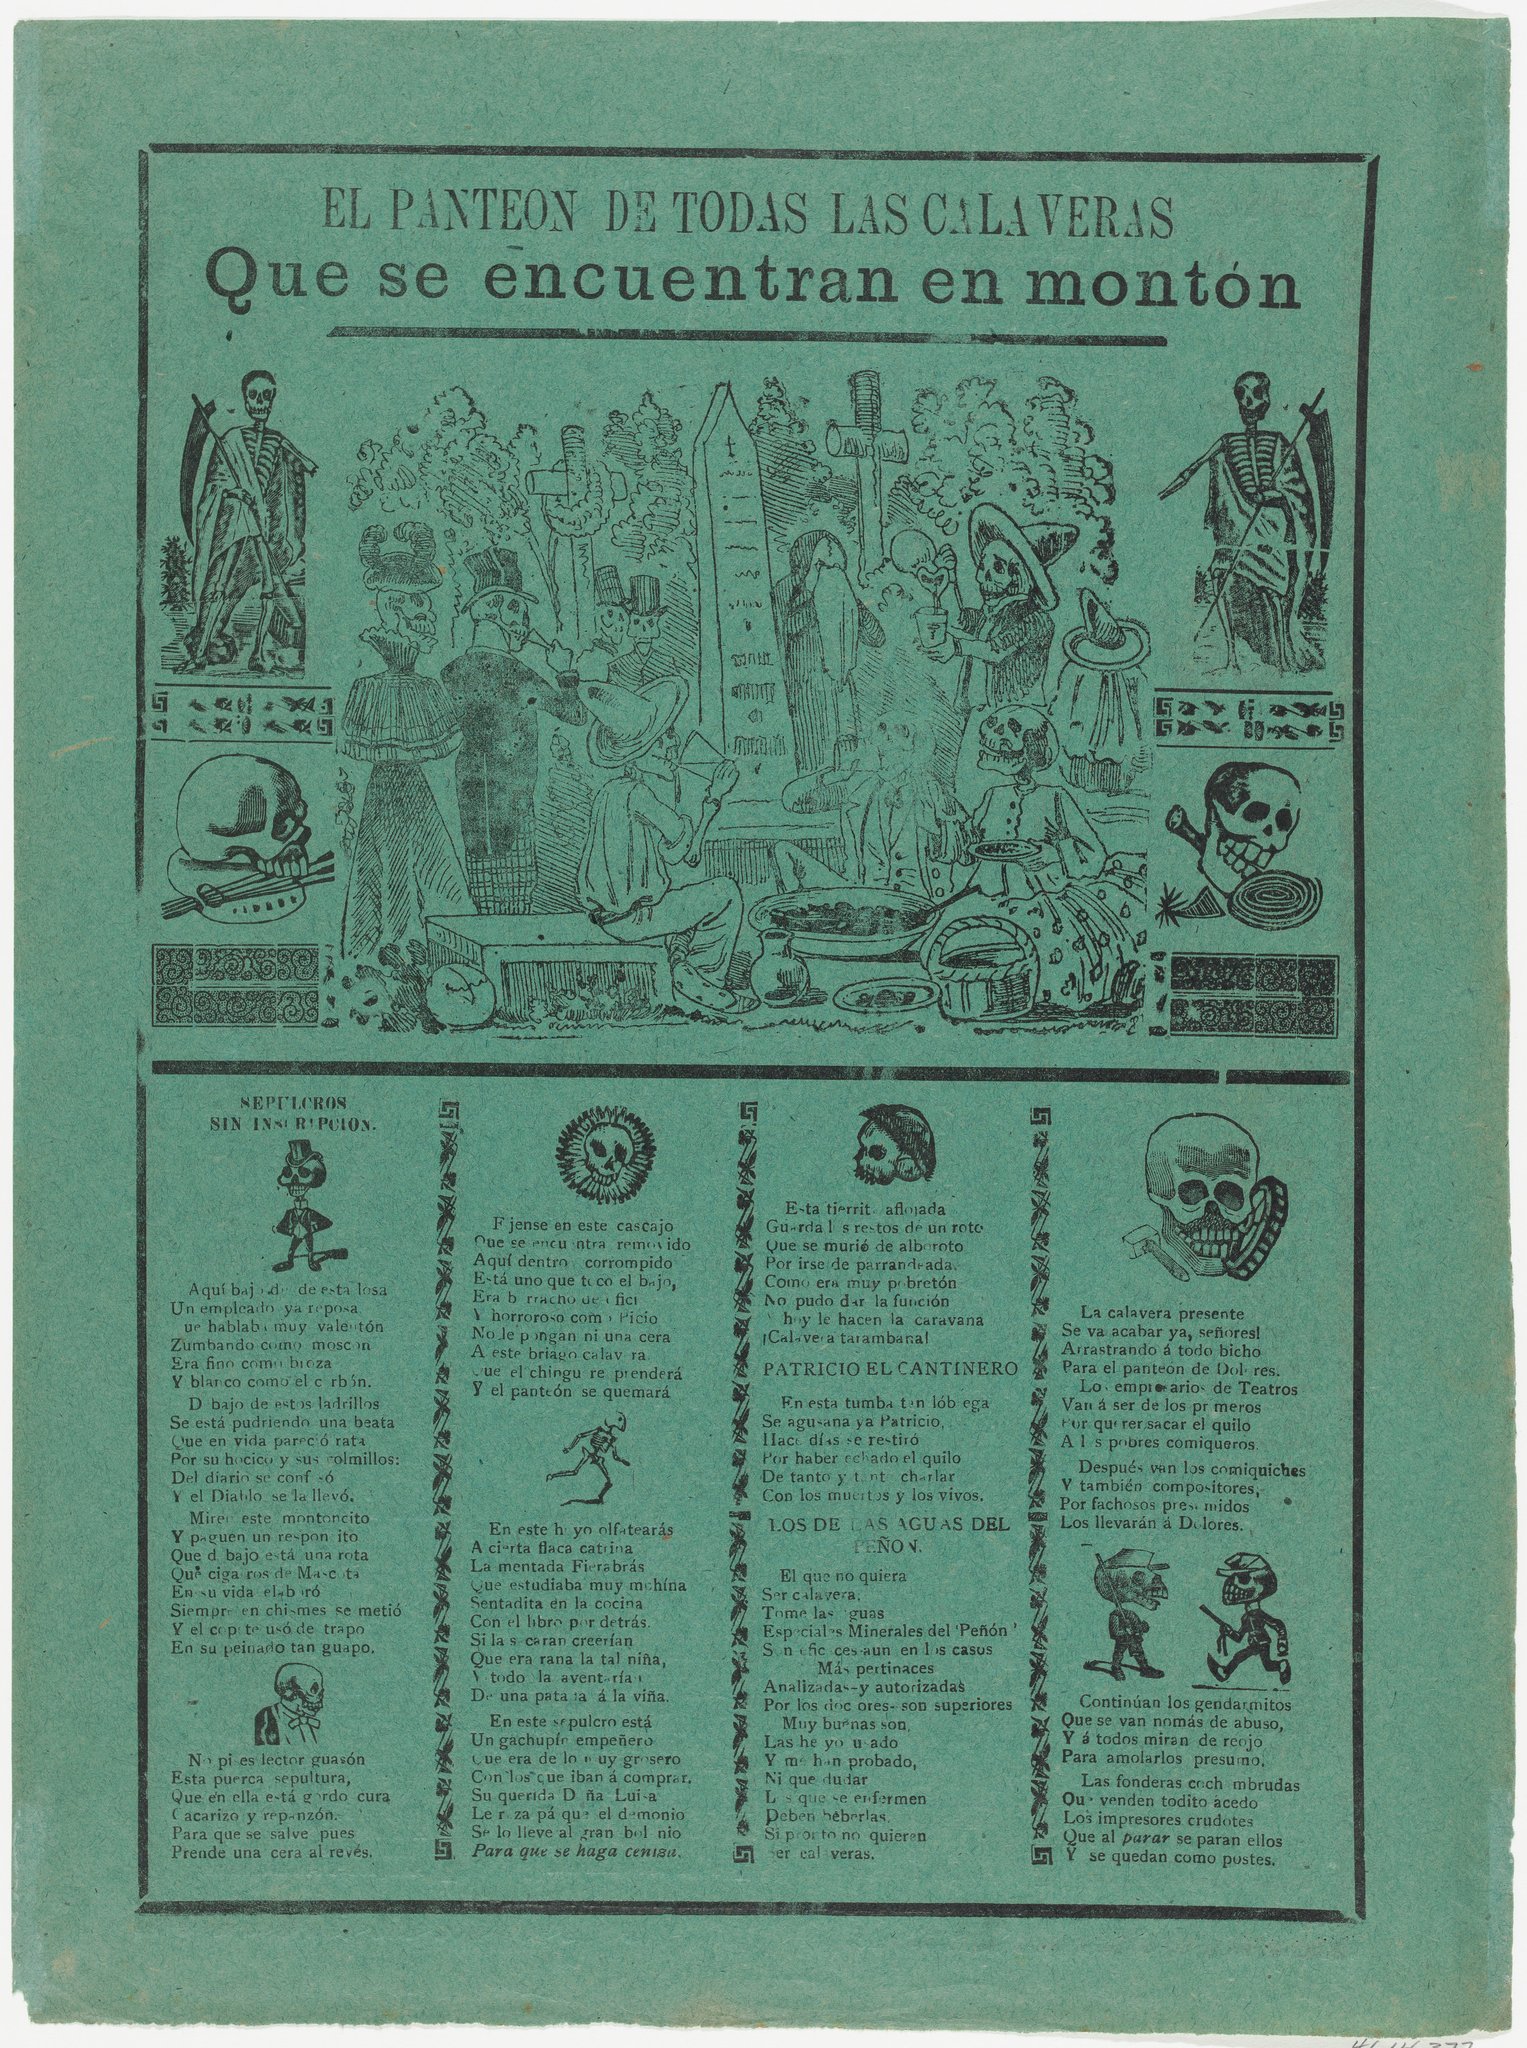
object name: print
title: The pantheon of all the skeletons who are eating and drinking in a cemetery (Posada); flanked by skeletons holding scythes (Manilla)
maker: josé guadalupe posada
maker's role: artist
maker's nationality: mexican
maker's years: 1852-1913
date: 1905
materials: metal, paper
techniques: engraving, letterpress, lithography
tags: burial grounds,weapons,skeletons,drinking